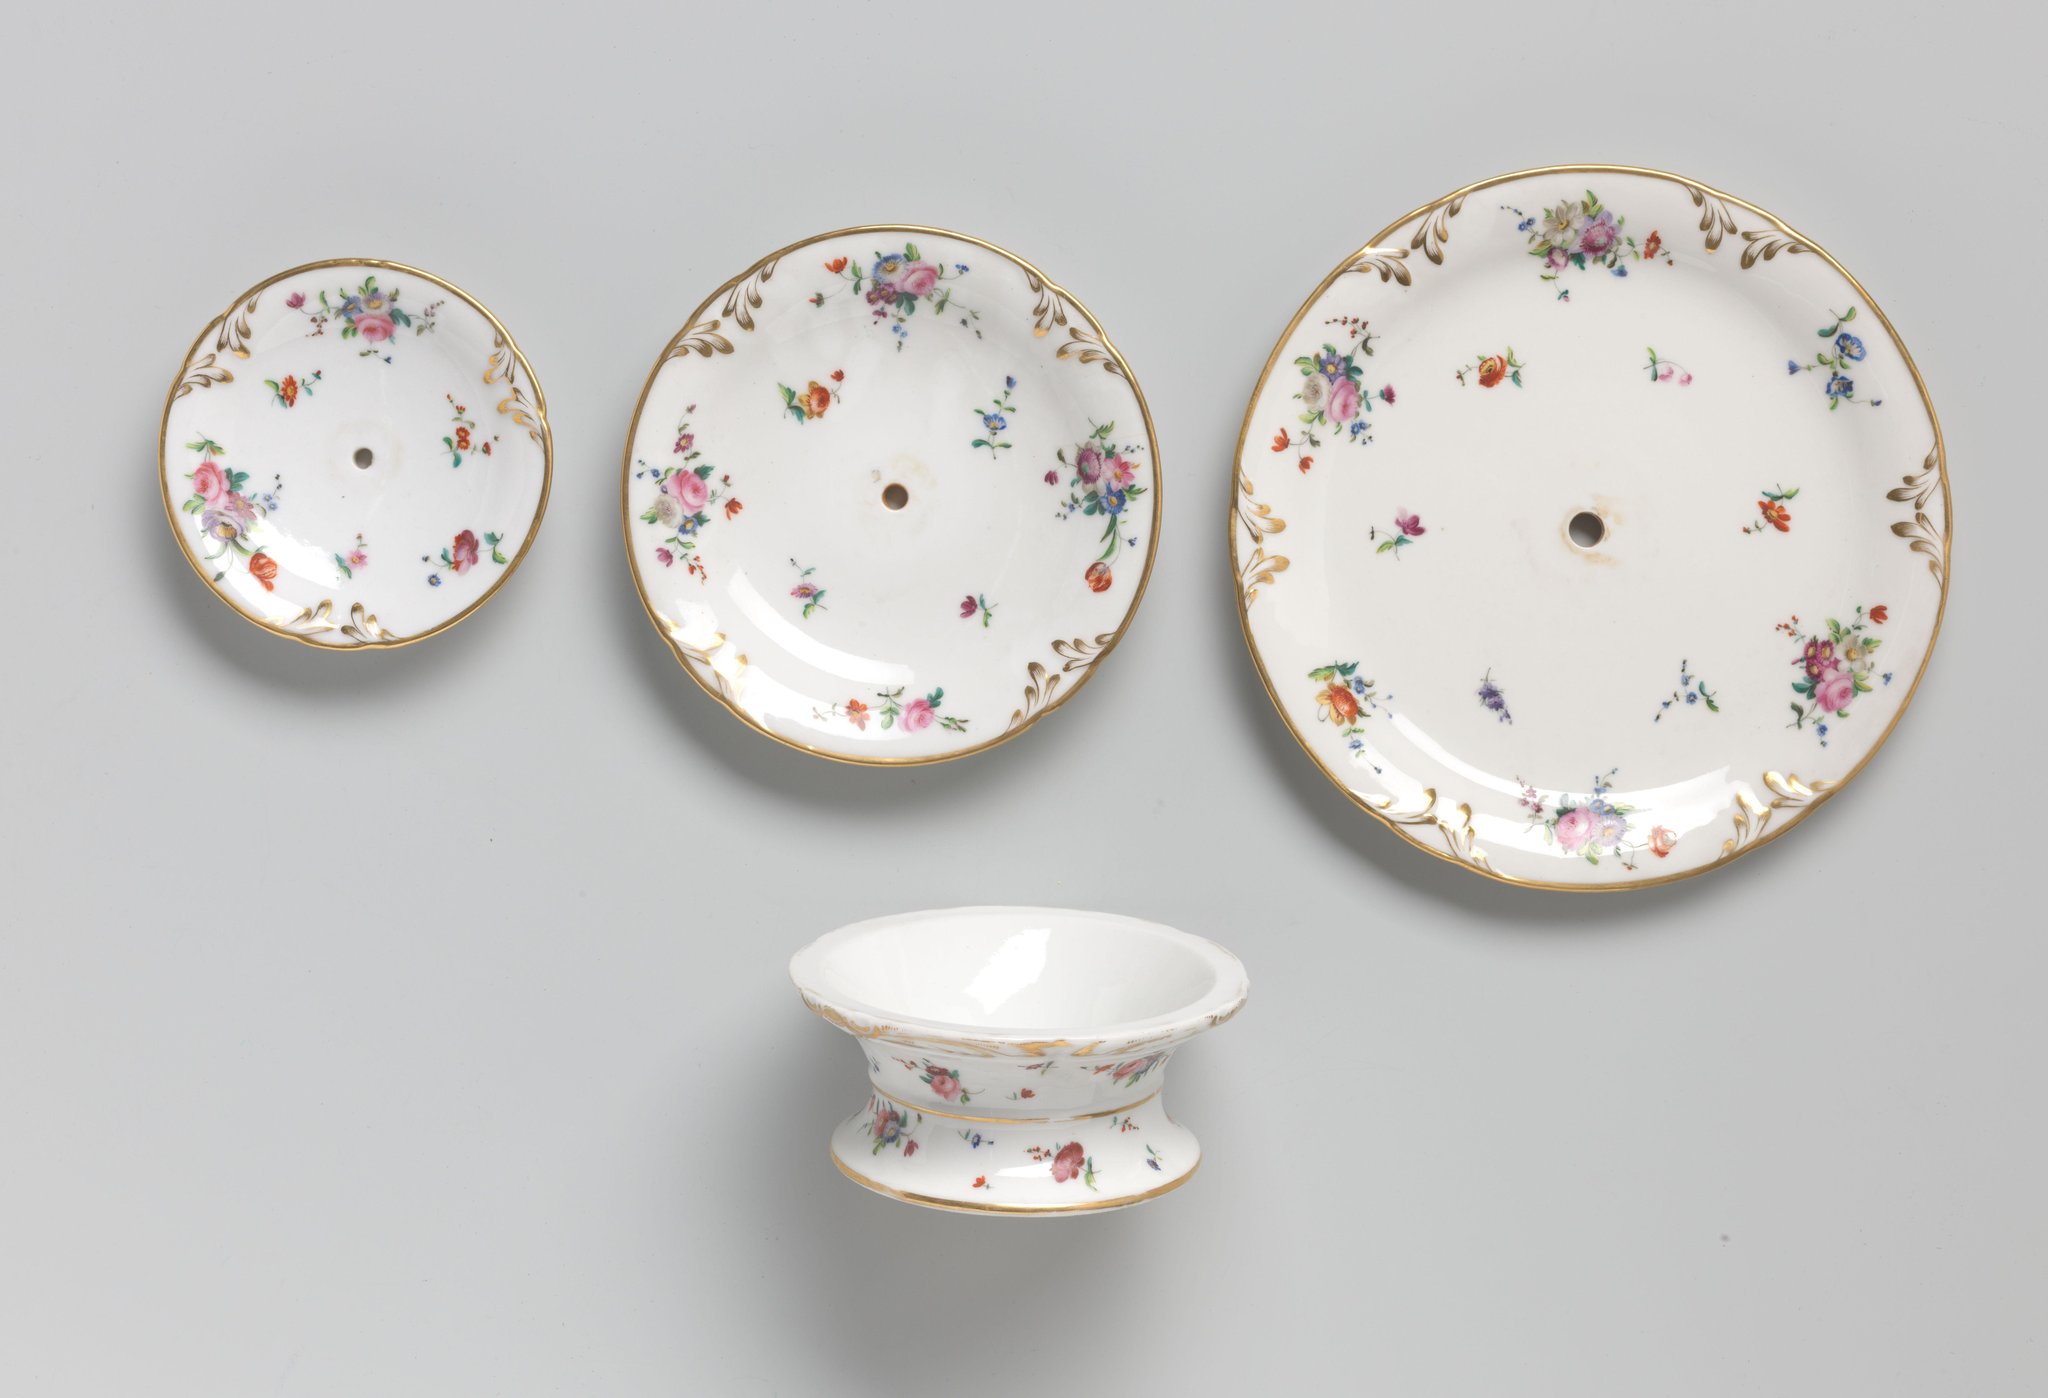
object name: service set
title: Dish of an etagere with bouquets and flower sprays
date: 1839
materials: glaze, gold, paint, porcelain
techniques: firing, forming, gilding, turning, vitrification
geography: paris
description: De grootste schaal van een étagère van porselein, beschilderd op het glazuur in blauw, rood, roze, groen, geel, paars, zwart en goud. Versierd op de voor- en achterzijde met boeketten van verschillende bloemen en strooibloemen. Vanuit de gelobde, gouden rand, gemodelleerde bladranken, aangezet met goud.